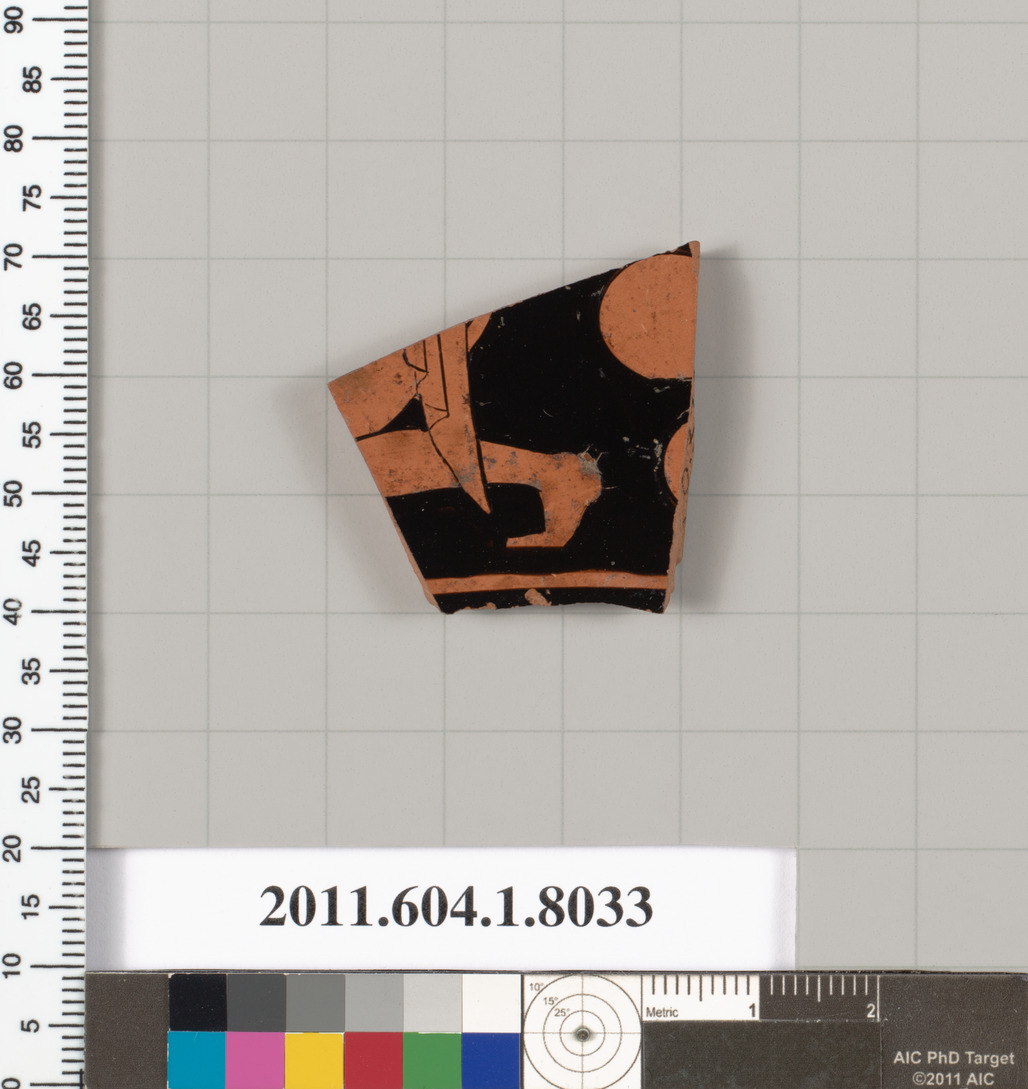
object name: kylix fragment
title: Terracotta fragment of a kylix (drinking cup)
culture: greek, attic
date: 510-500 BCE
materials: terracotta